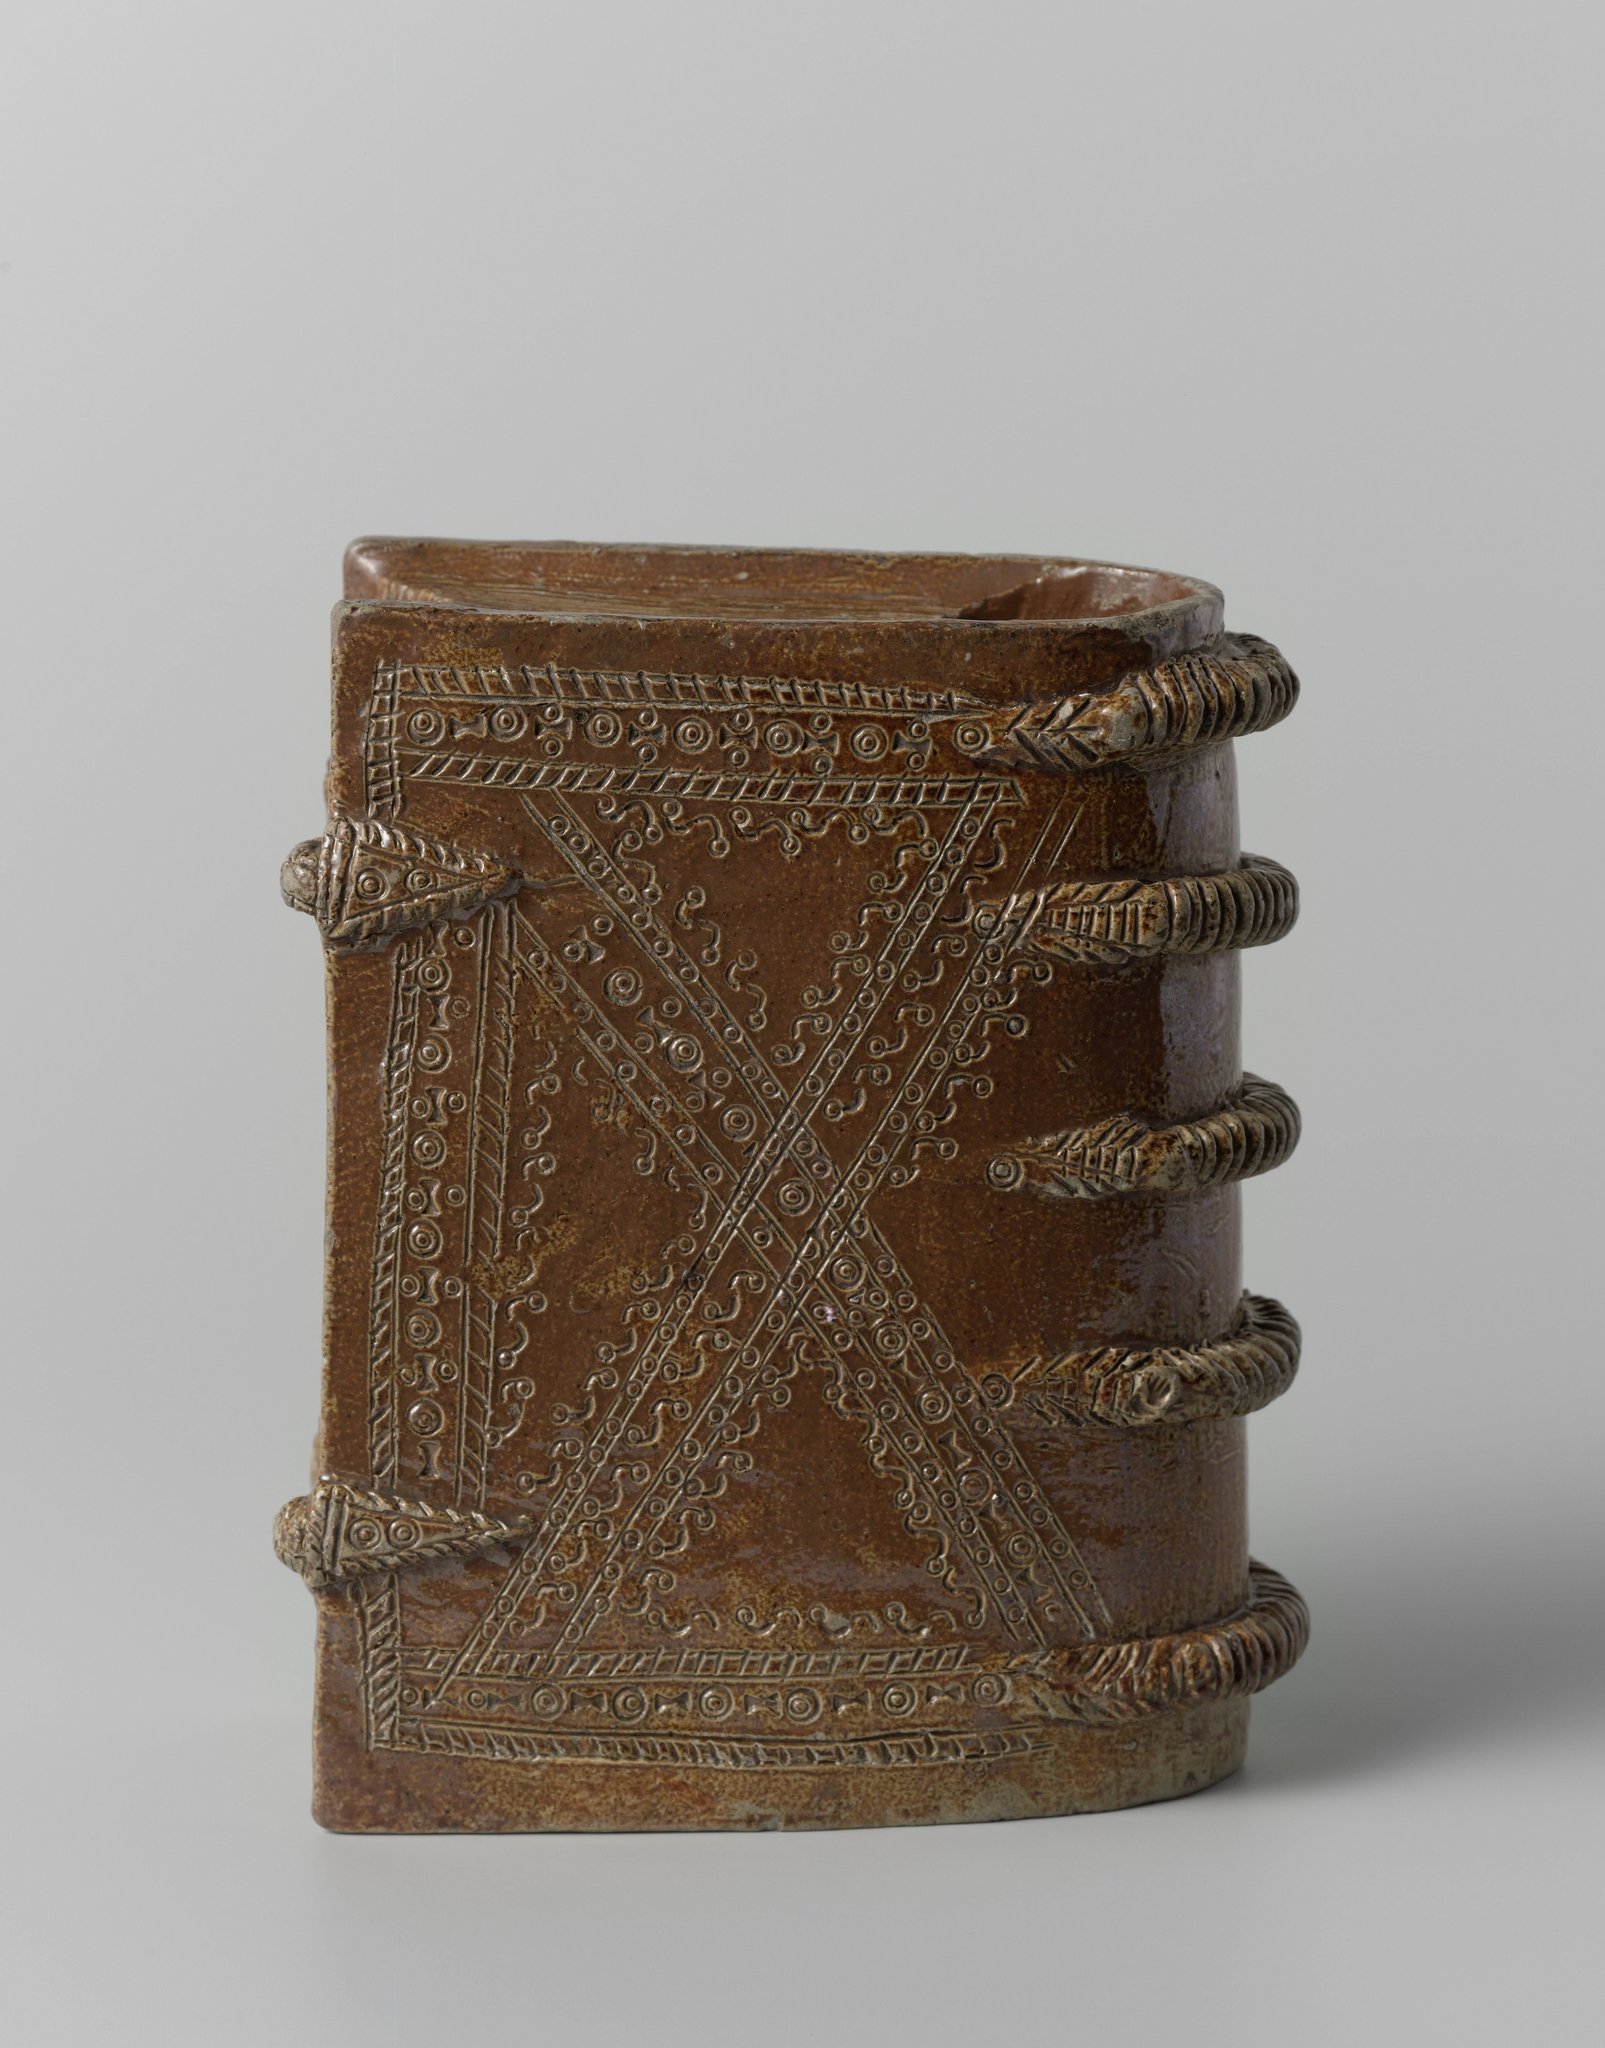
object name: cup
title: Drinking vessel in the shape of a book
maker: Anonymous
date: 1600-1615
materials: engobe, glaze, stoneware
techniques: printing, firing, forming, relief, turning, vitrification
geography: raeren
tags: book, belgium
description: From a distance, this beaker looks like a book bound in leather, but it is a deceptive imitation, complete with book clasps and a handsomely embellished front and back cover, in glazed earthenware. The drink opening is on the top, just behind the book’s spine.